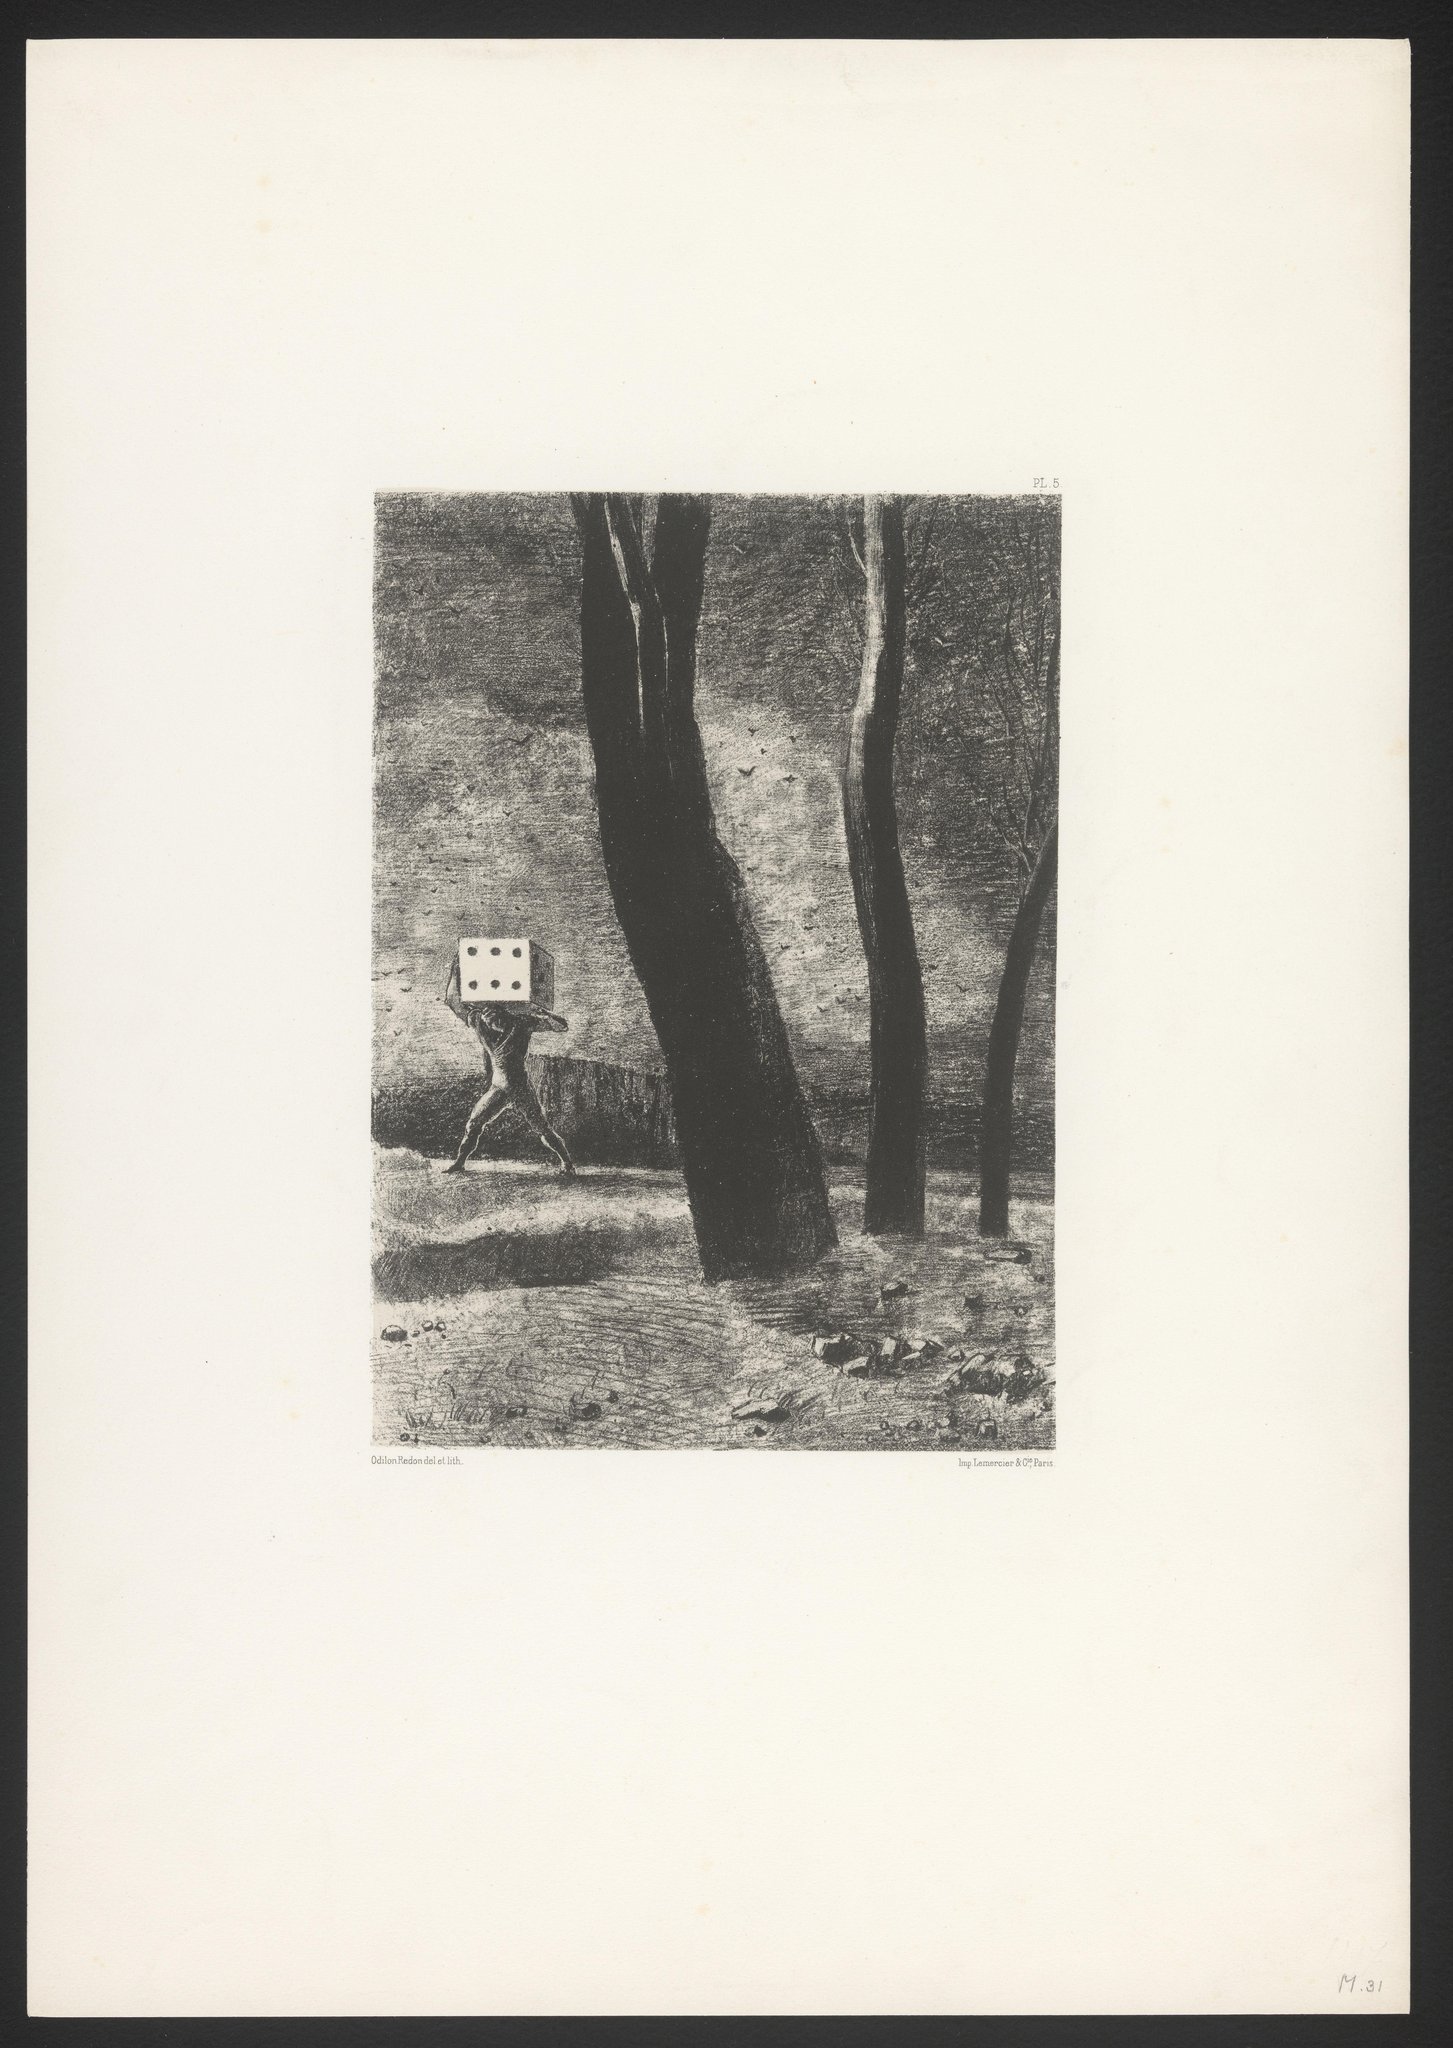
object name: print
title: In de droom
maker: odilon redon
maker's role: draughtsman, painter, print maker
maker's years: 1840-1916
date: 1879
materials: paper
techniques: lithograph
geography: paris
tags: trees, walking, dice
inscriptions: collector's mark: Lugt 2228, collector's mark: Lugt 2760